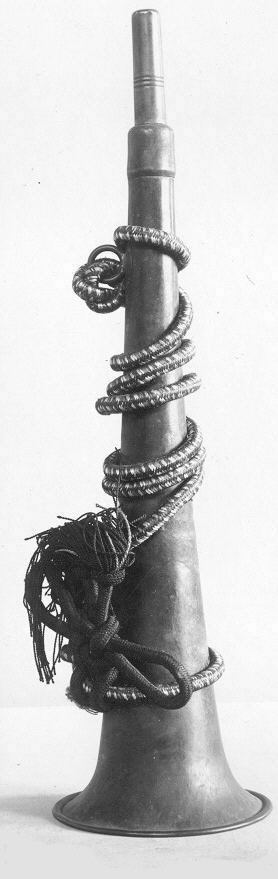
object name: dosa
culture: japanese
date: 1801-1900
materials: copper, cord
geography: japan